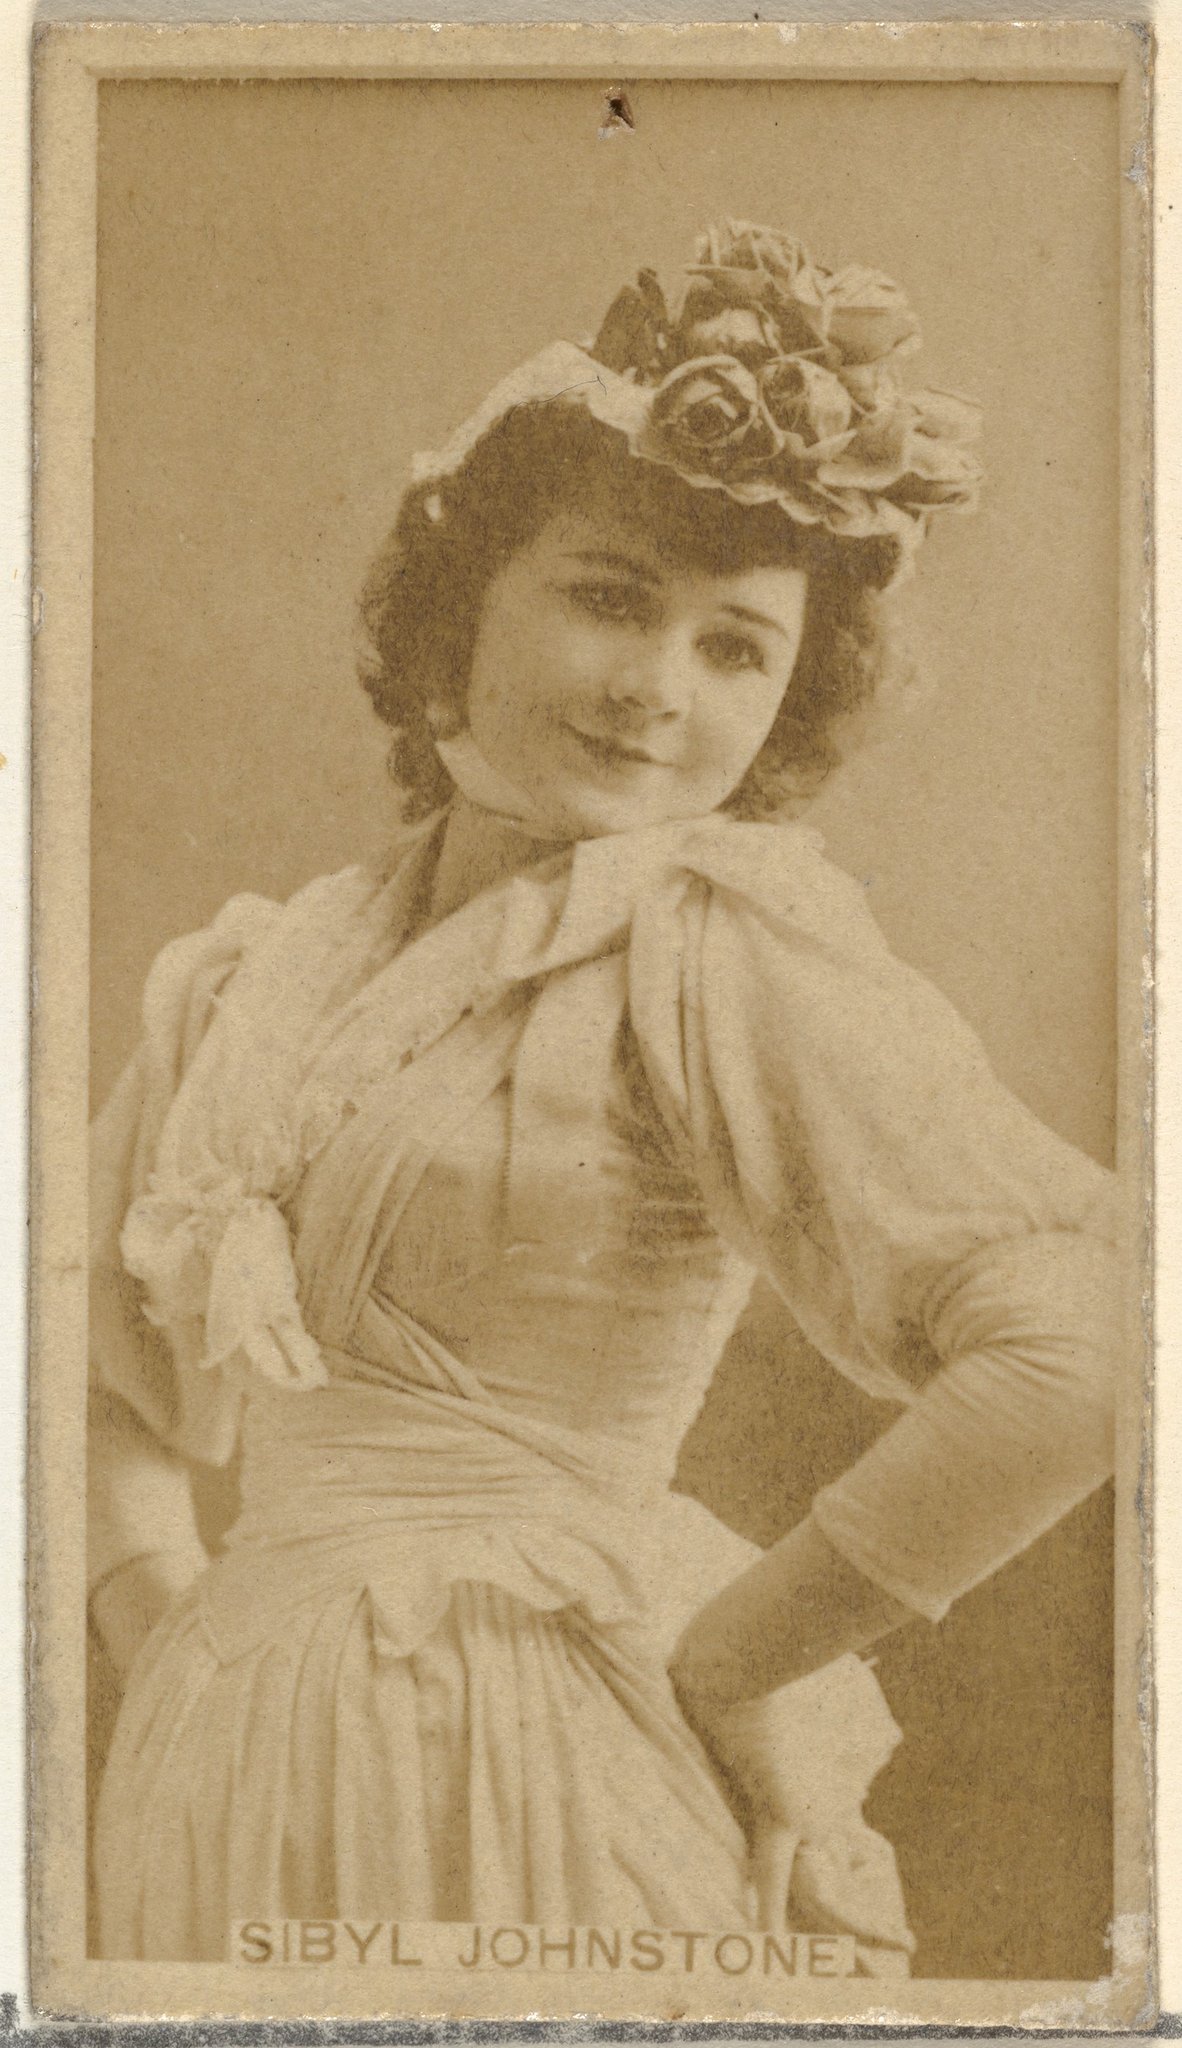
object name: photograph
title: Sibyl Johnstone, from the Actors and Actresses series (N145-8) issued by Duke Sons & Co. to promote Duke Cigarettes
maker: w. duke, sons & co.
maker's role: publisher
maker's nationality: american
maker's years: 1870-1920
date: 1891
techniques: albumen silver print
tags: portraits,women,actresses